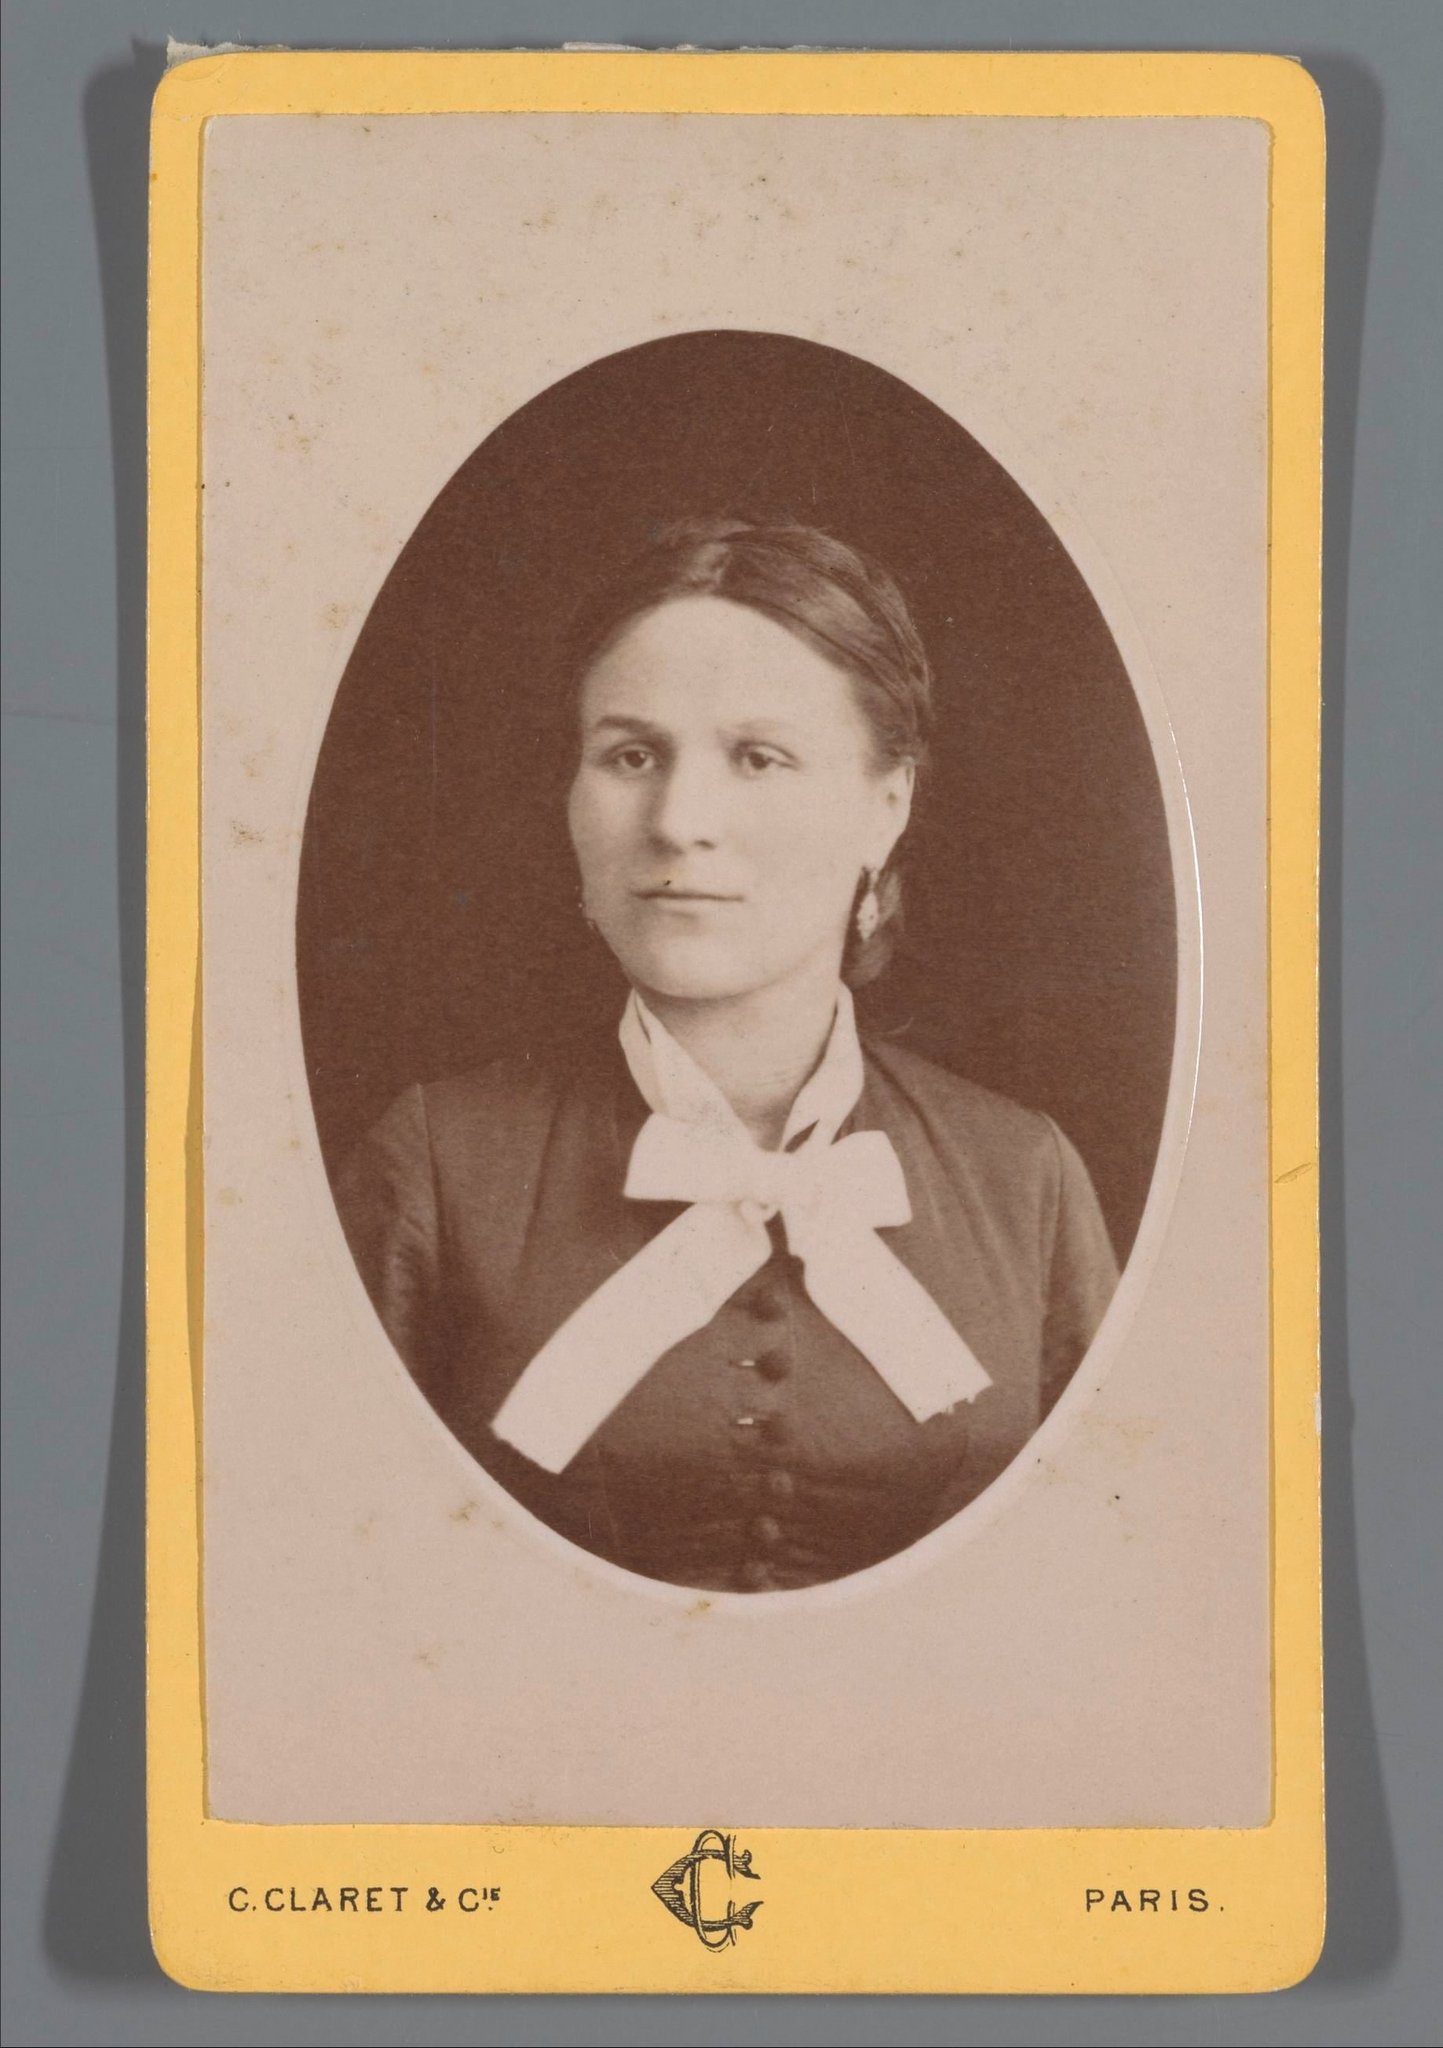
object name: carte de visite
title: Portret van een onbekende vrouw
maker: clovis claret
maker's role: fotograaf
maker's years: 1852-1907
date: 1875-1888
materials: cardboard, celluloid, paper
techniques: albumen print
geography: paris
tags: adult woman, anonymous historical person portrayed, paris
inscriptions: monogram: ‘CC’, inscription: ‘C. Claret & Cie. Paris.’, inscription: ‘Photographie/ Chappellart/ C. Claret & Cie. Succrs./ 48, rue Vivienne, 48./ au coin du Bd. Montmartre/ Paris/ Indiquer ce No.../ pour avoir des cartes semblables.’